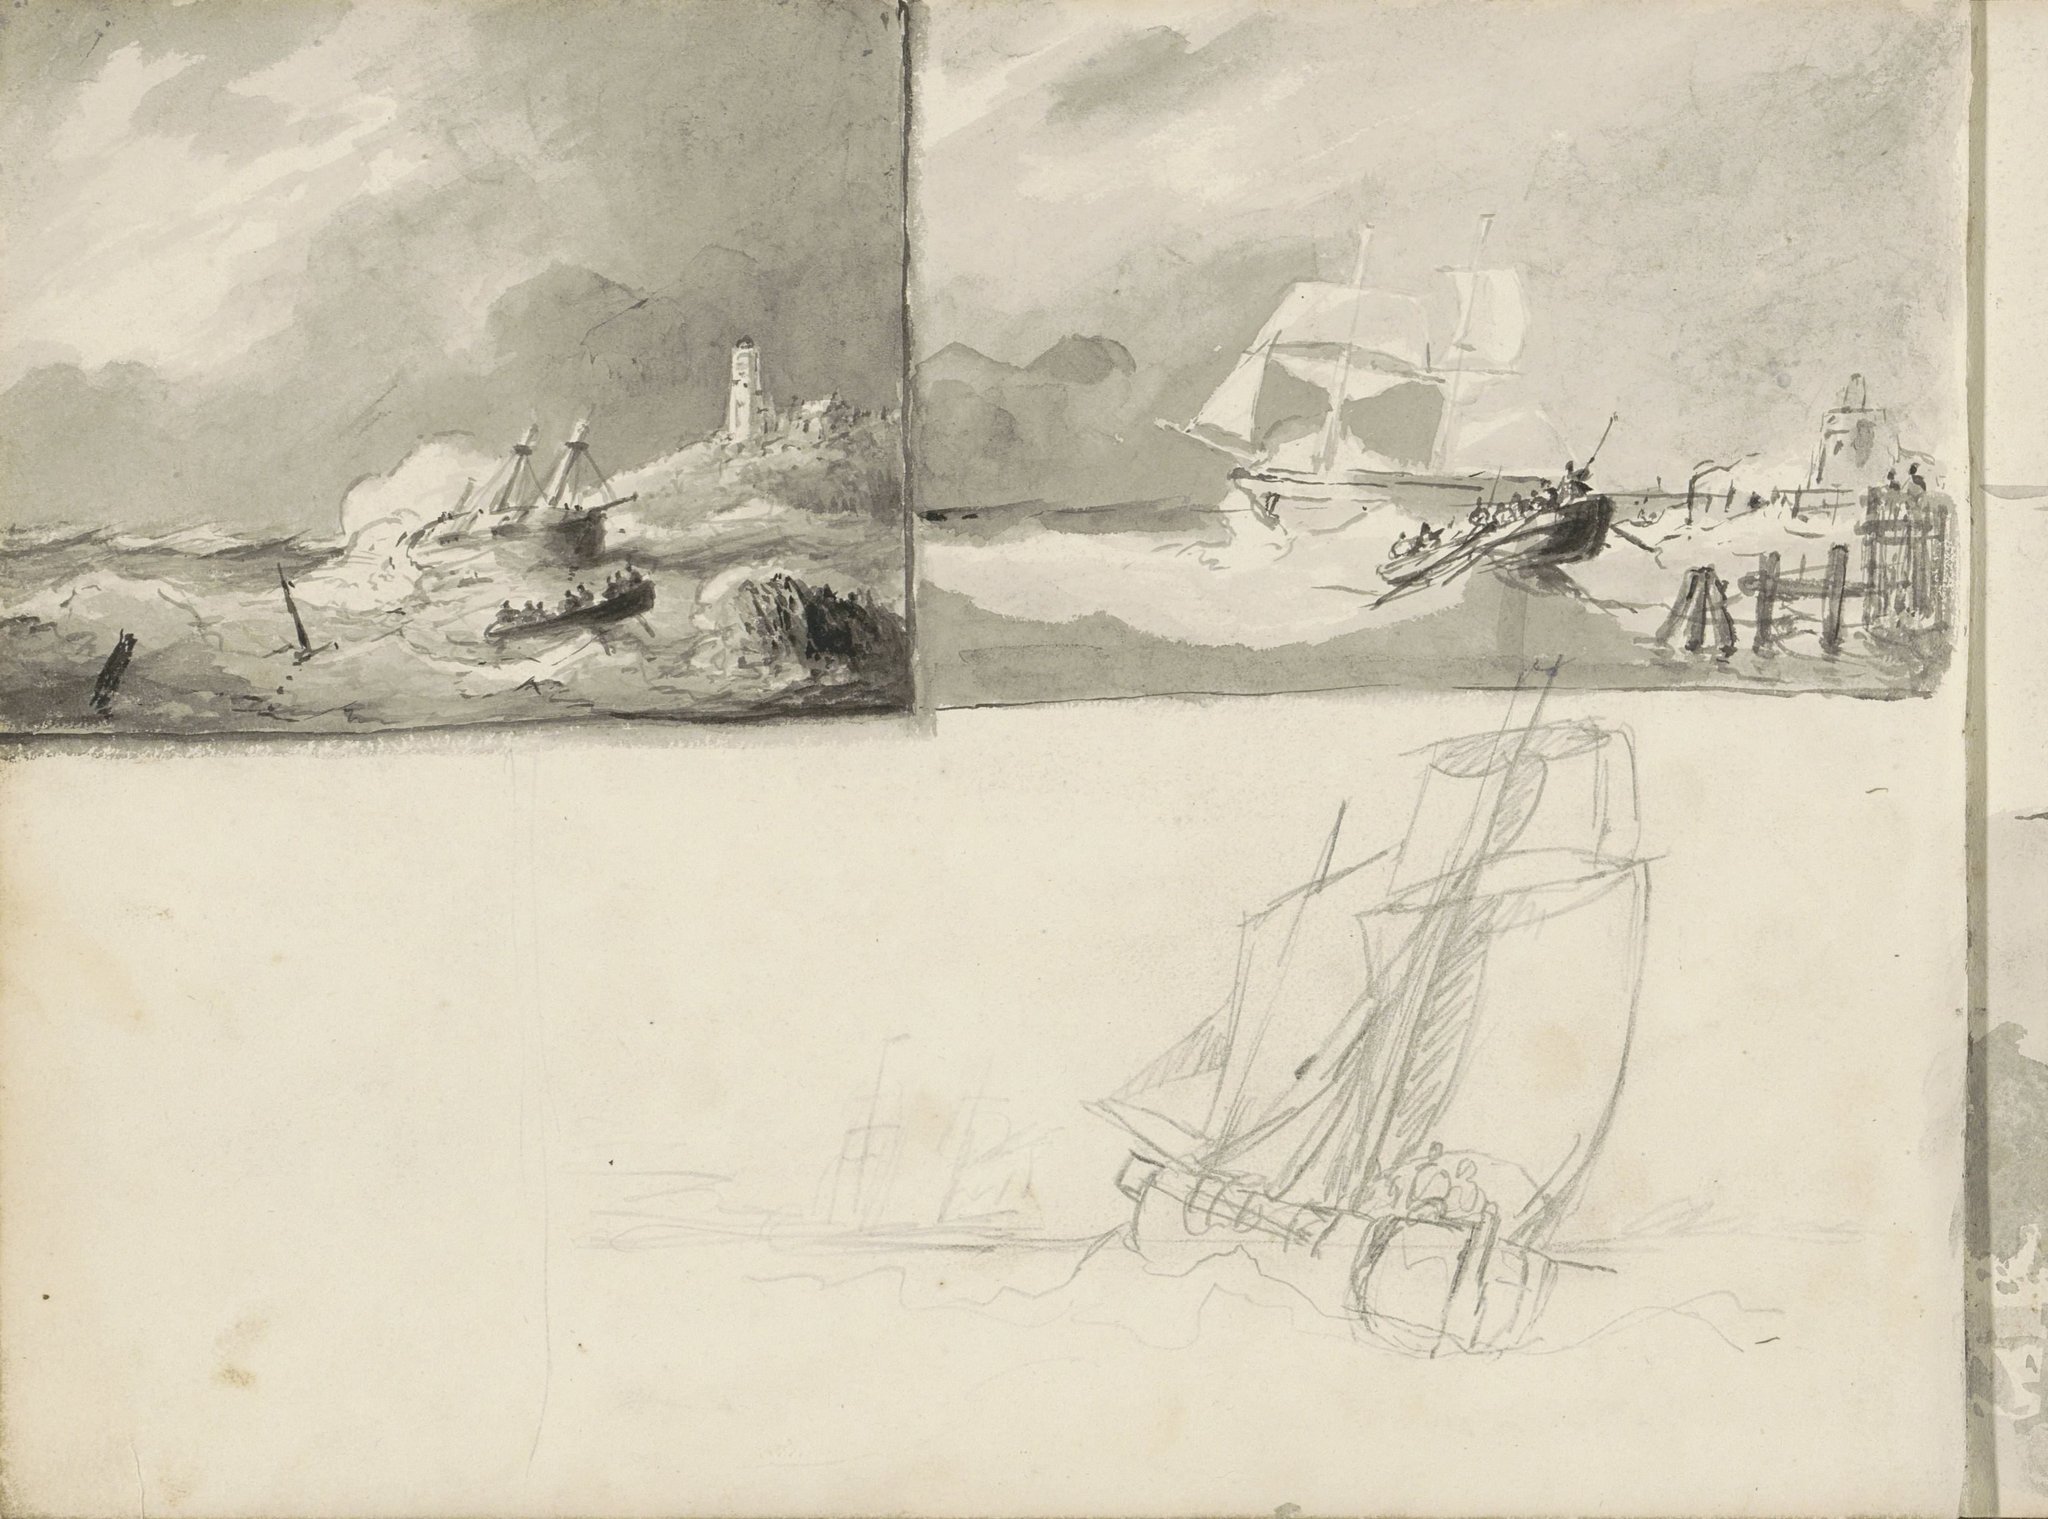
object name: sketchbook leaf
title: Drie zeegezichten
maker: petrus johannes schotel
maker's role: draughtsman, painter, print maker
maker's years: 1808-1865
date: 1825-1875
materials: paper, pencil, watercolor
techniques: brush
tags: sea (seascape), storm at sea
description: Twee studies van schepen (in nood) voor een kust en van een zeilschip op zee. Blad 15 verso uit een schetsboek met 44 bladen.